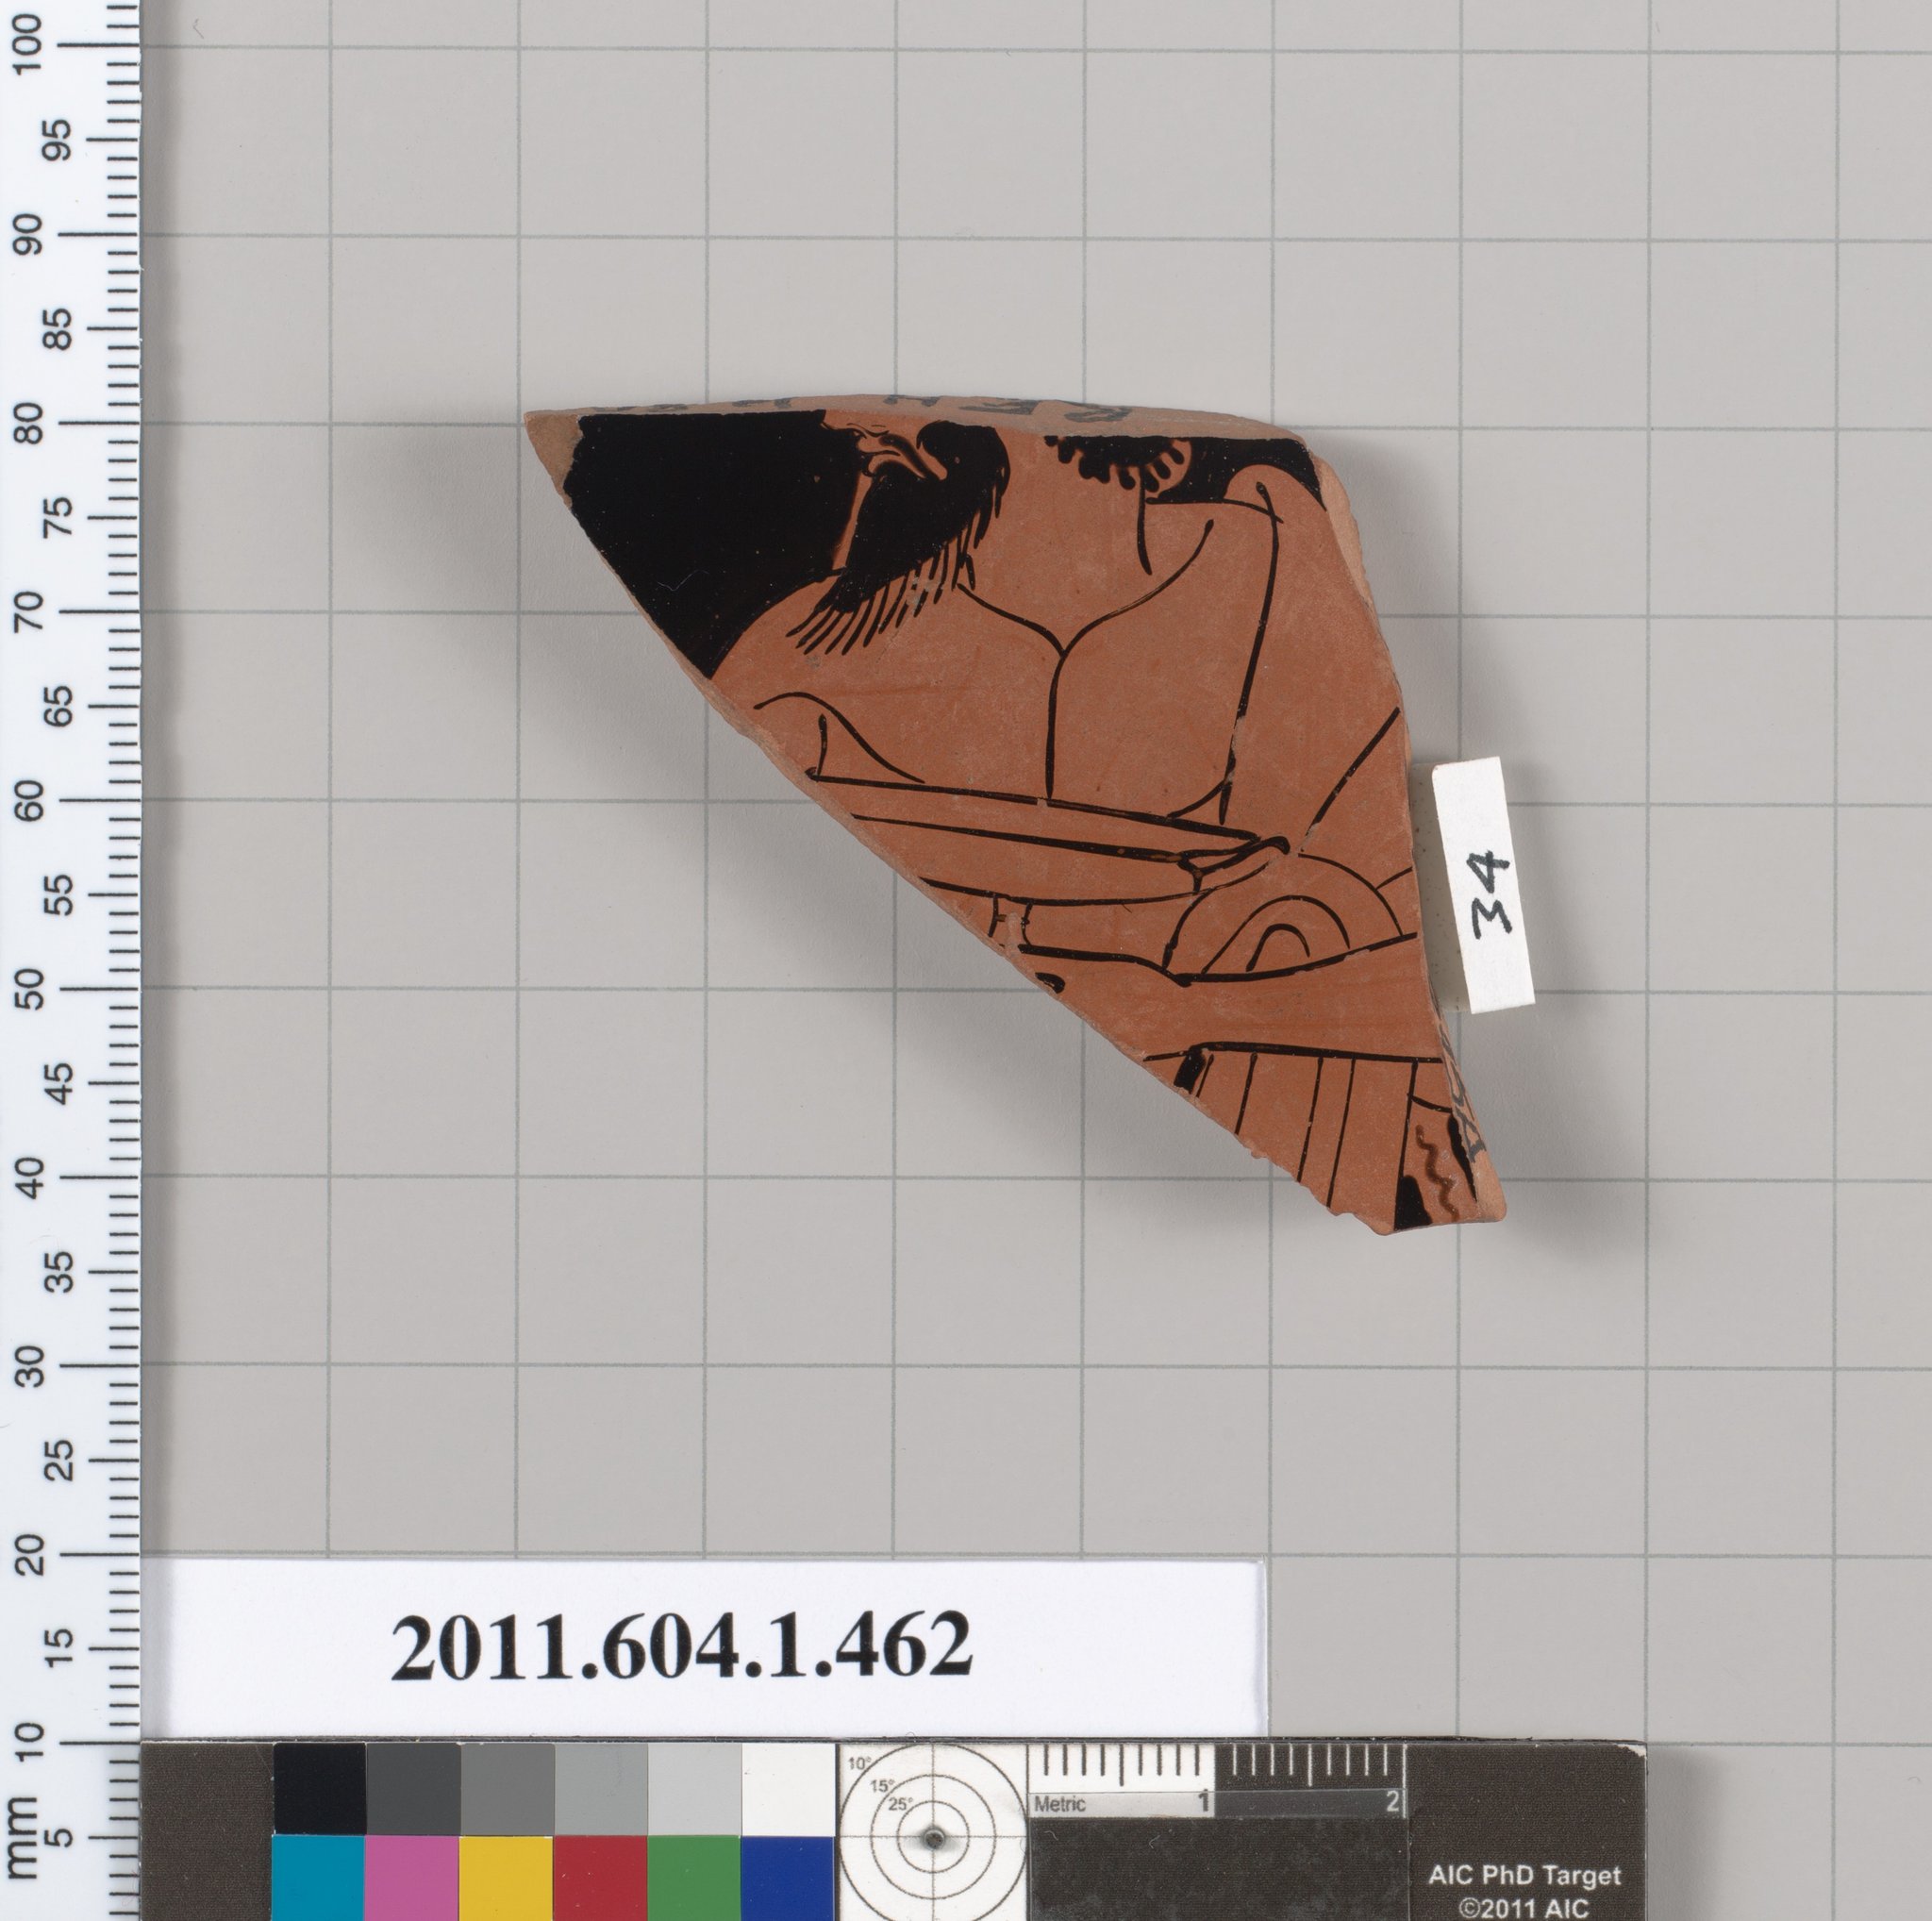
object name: kylix fragment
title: Terracotta fragment of a kylix (drinking cup)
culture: greek, attic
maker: makron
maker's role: artist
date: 490-480 BCE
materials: terracotta